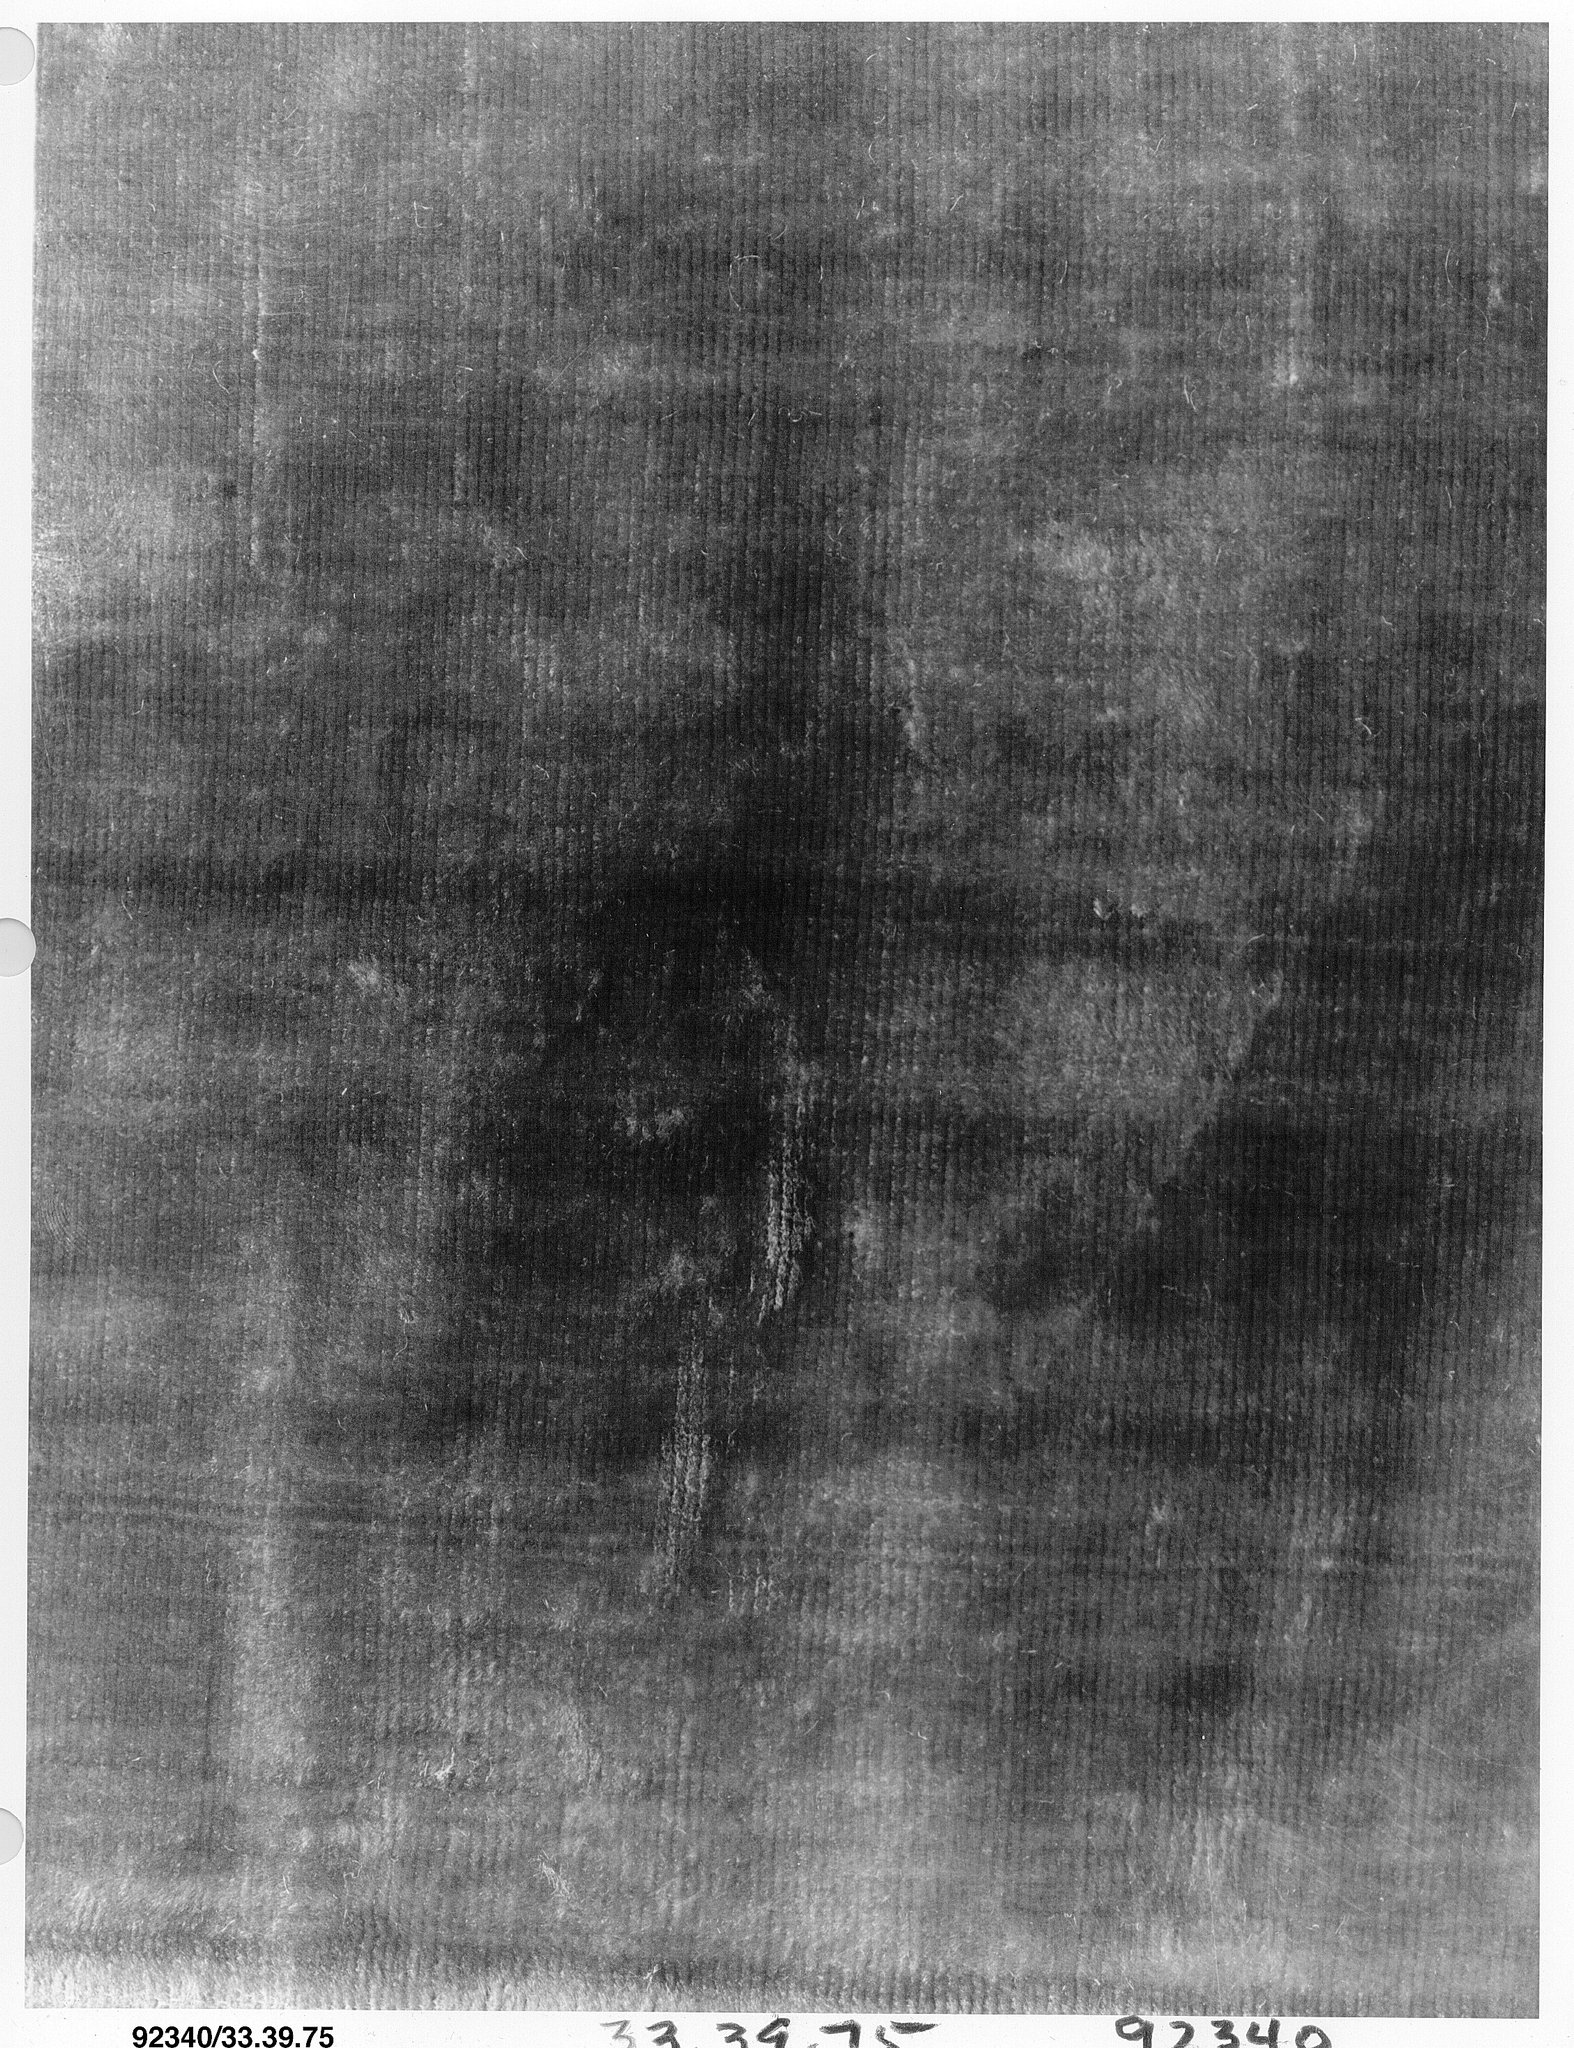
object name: fragment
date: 1801-1900